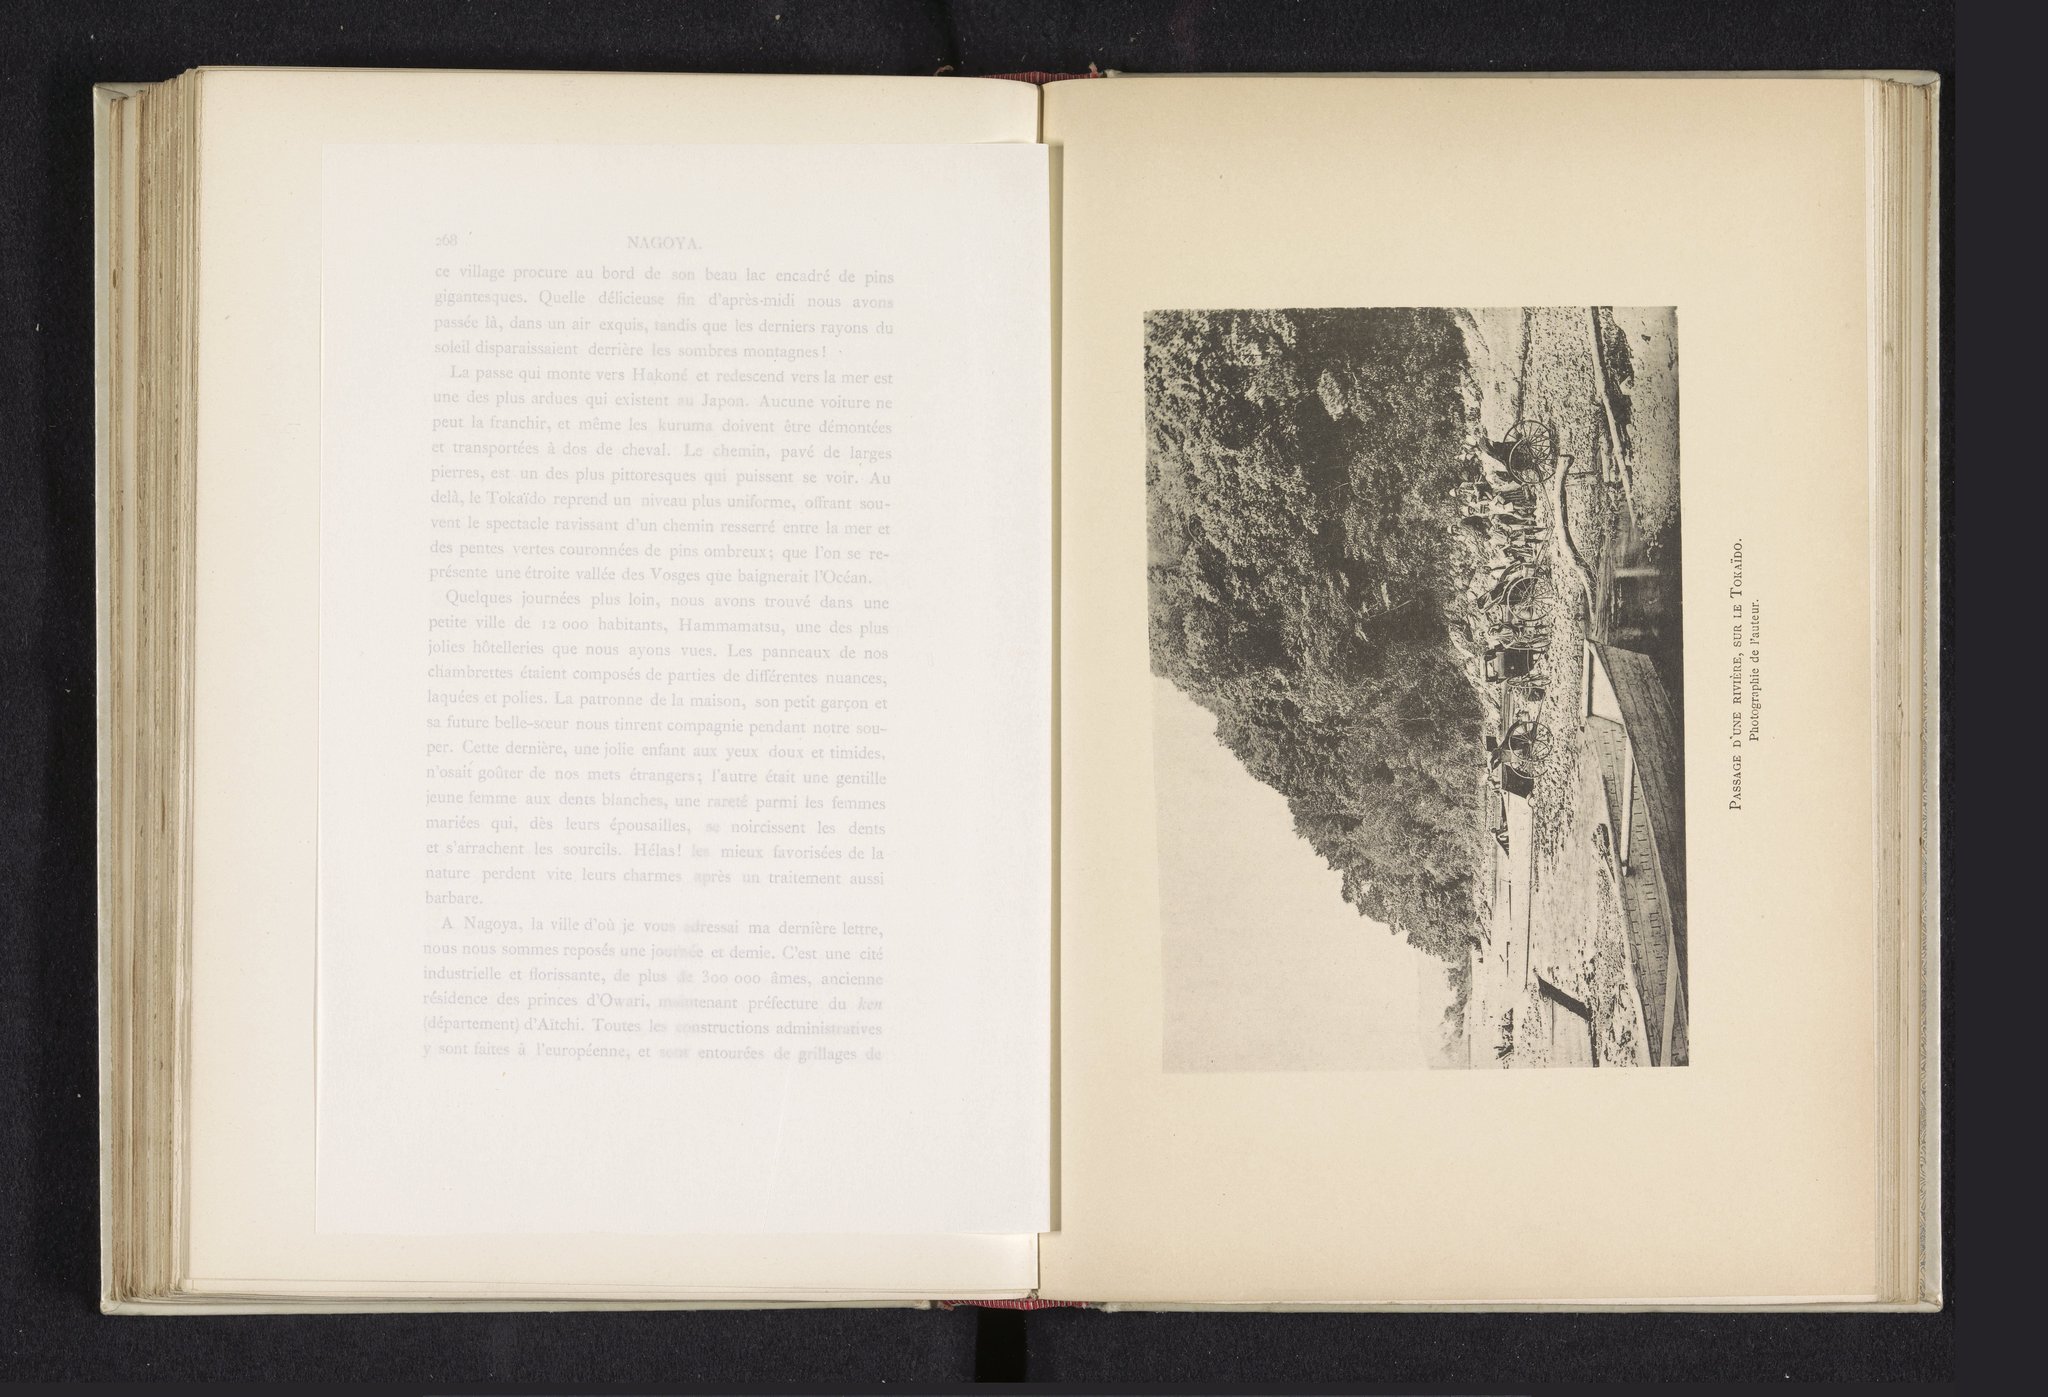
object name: page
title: Passage d'une rivière, sur le Tokaïdo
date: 1882-1883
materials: paper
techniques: photograph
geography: tokaido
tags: crossing a river, rickshaw, river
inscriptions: inscription: ‘Photographie de l'auteur.’